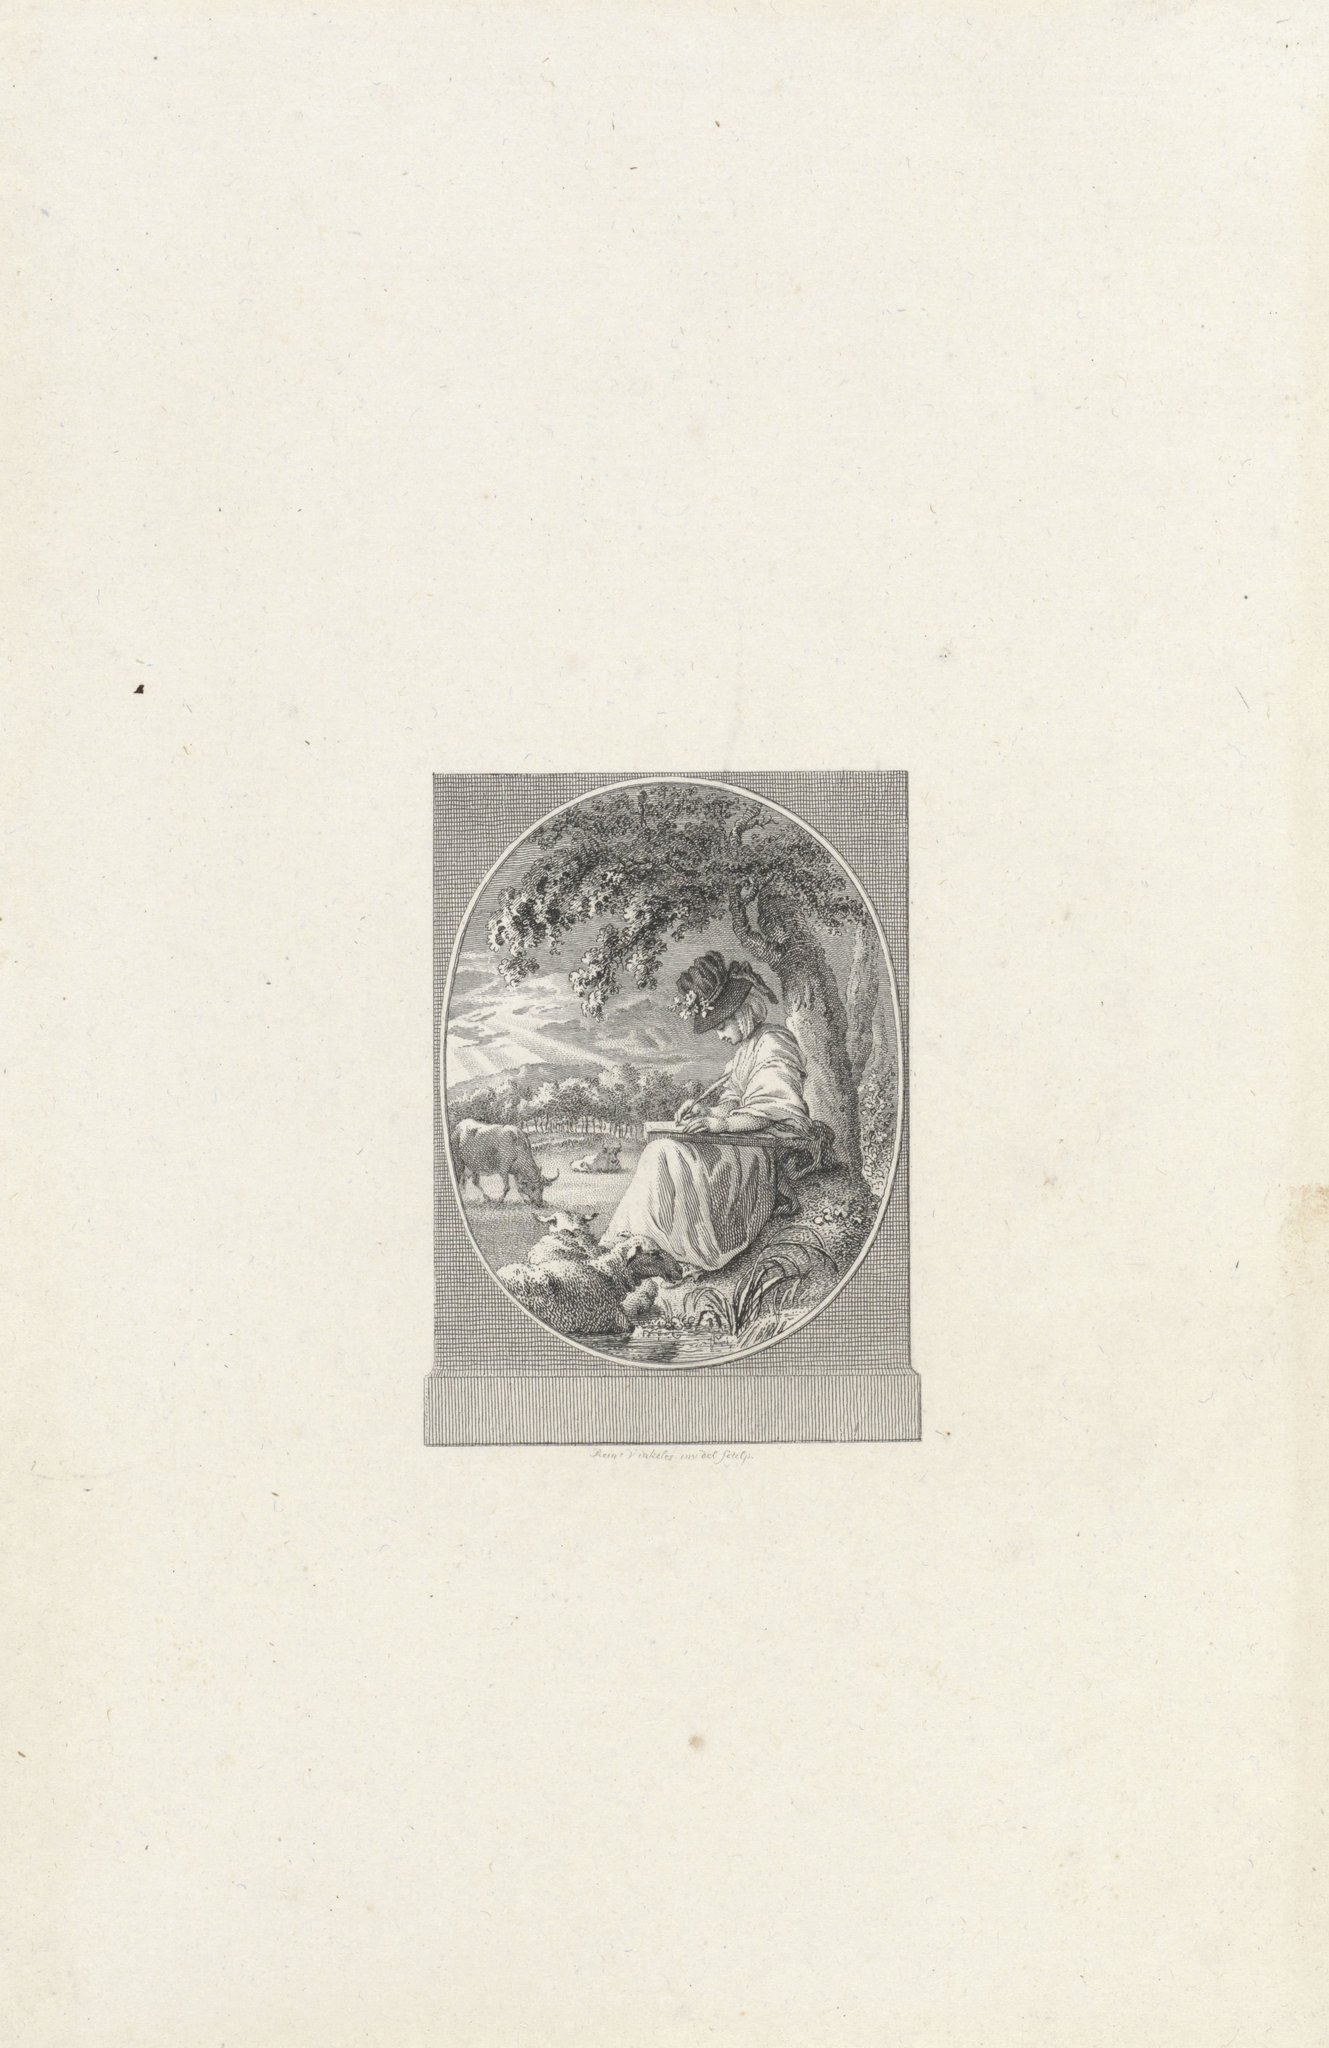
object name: print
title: Titelpagina voor: Elisabeth Maria Post, Reinhart, of Natuur en Godsdienst, dl. 1, 1791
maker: reinier vinkeles (i)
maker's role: draughtsman, print maker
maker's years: 1741-1816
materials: paper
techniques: engraving, etching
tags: landscapes, cattle, slavery; serfs and enslaved persons, sheep, writer, poet, author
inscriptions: collector's mark: Lugt 240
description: Titelpagina met een landschap waarin een jonge vrouw onder een boom zit te schrijven. Voor haar liggen twee schapen en op de achtergrond zijn grazende runderen te zien.